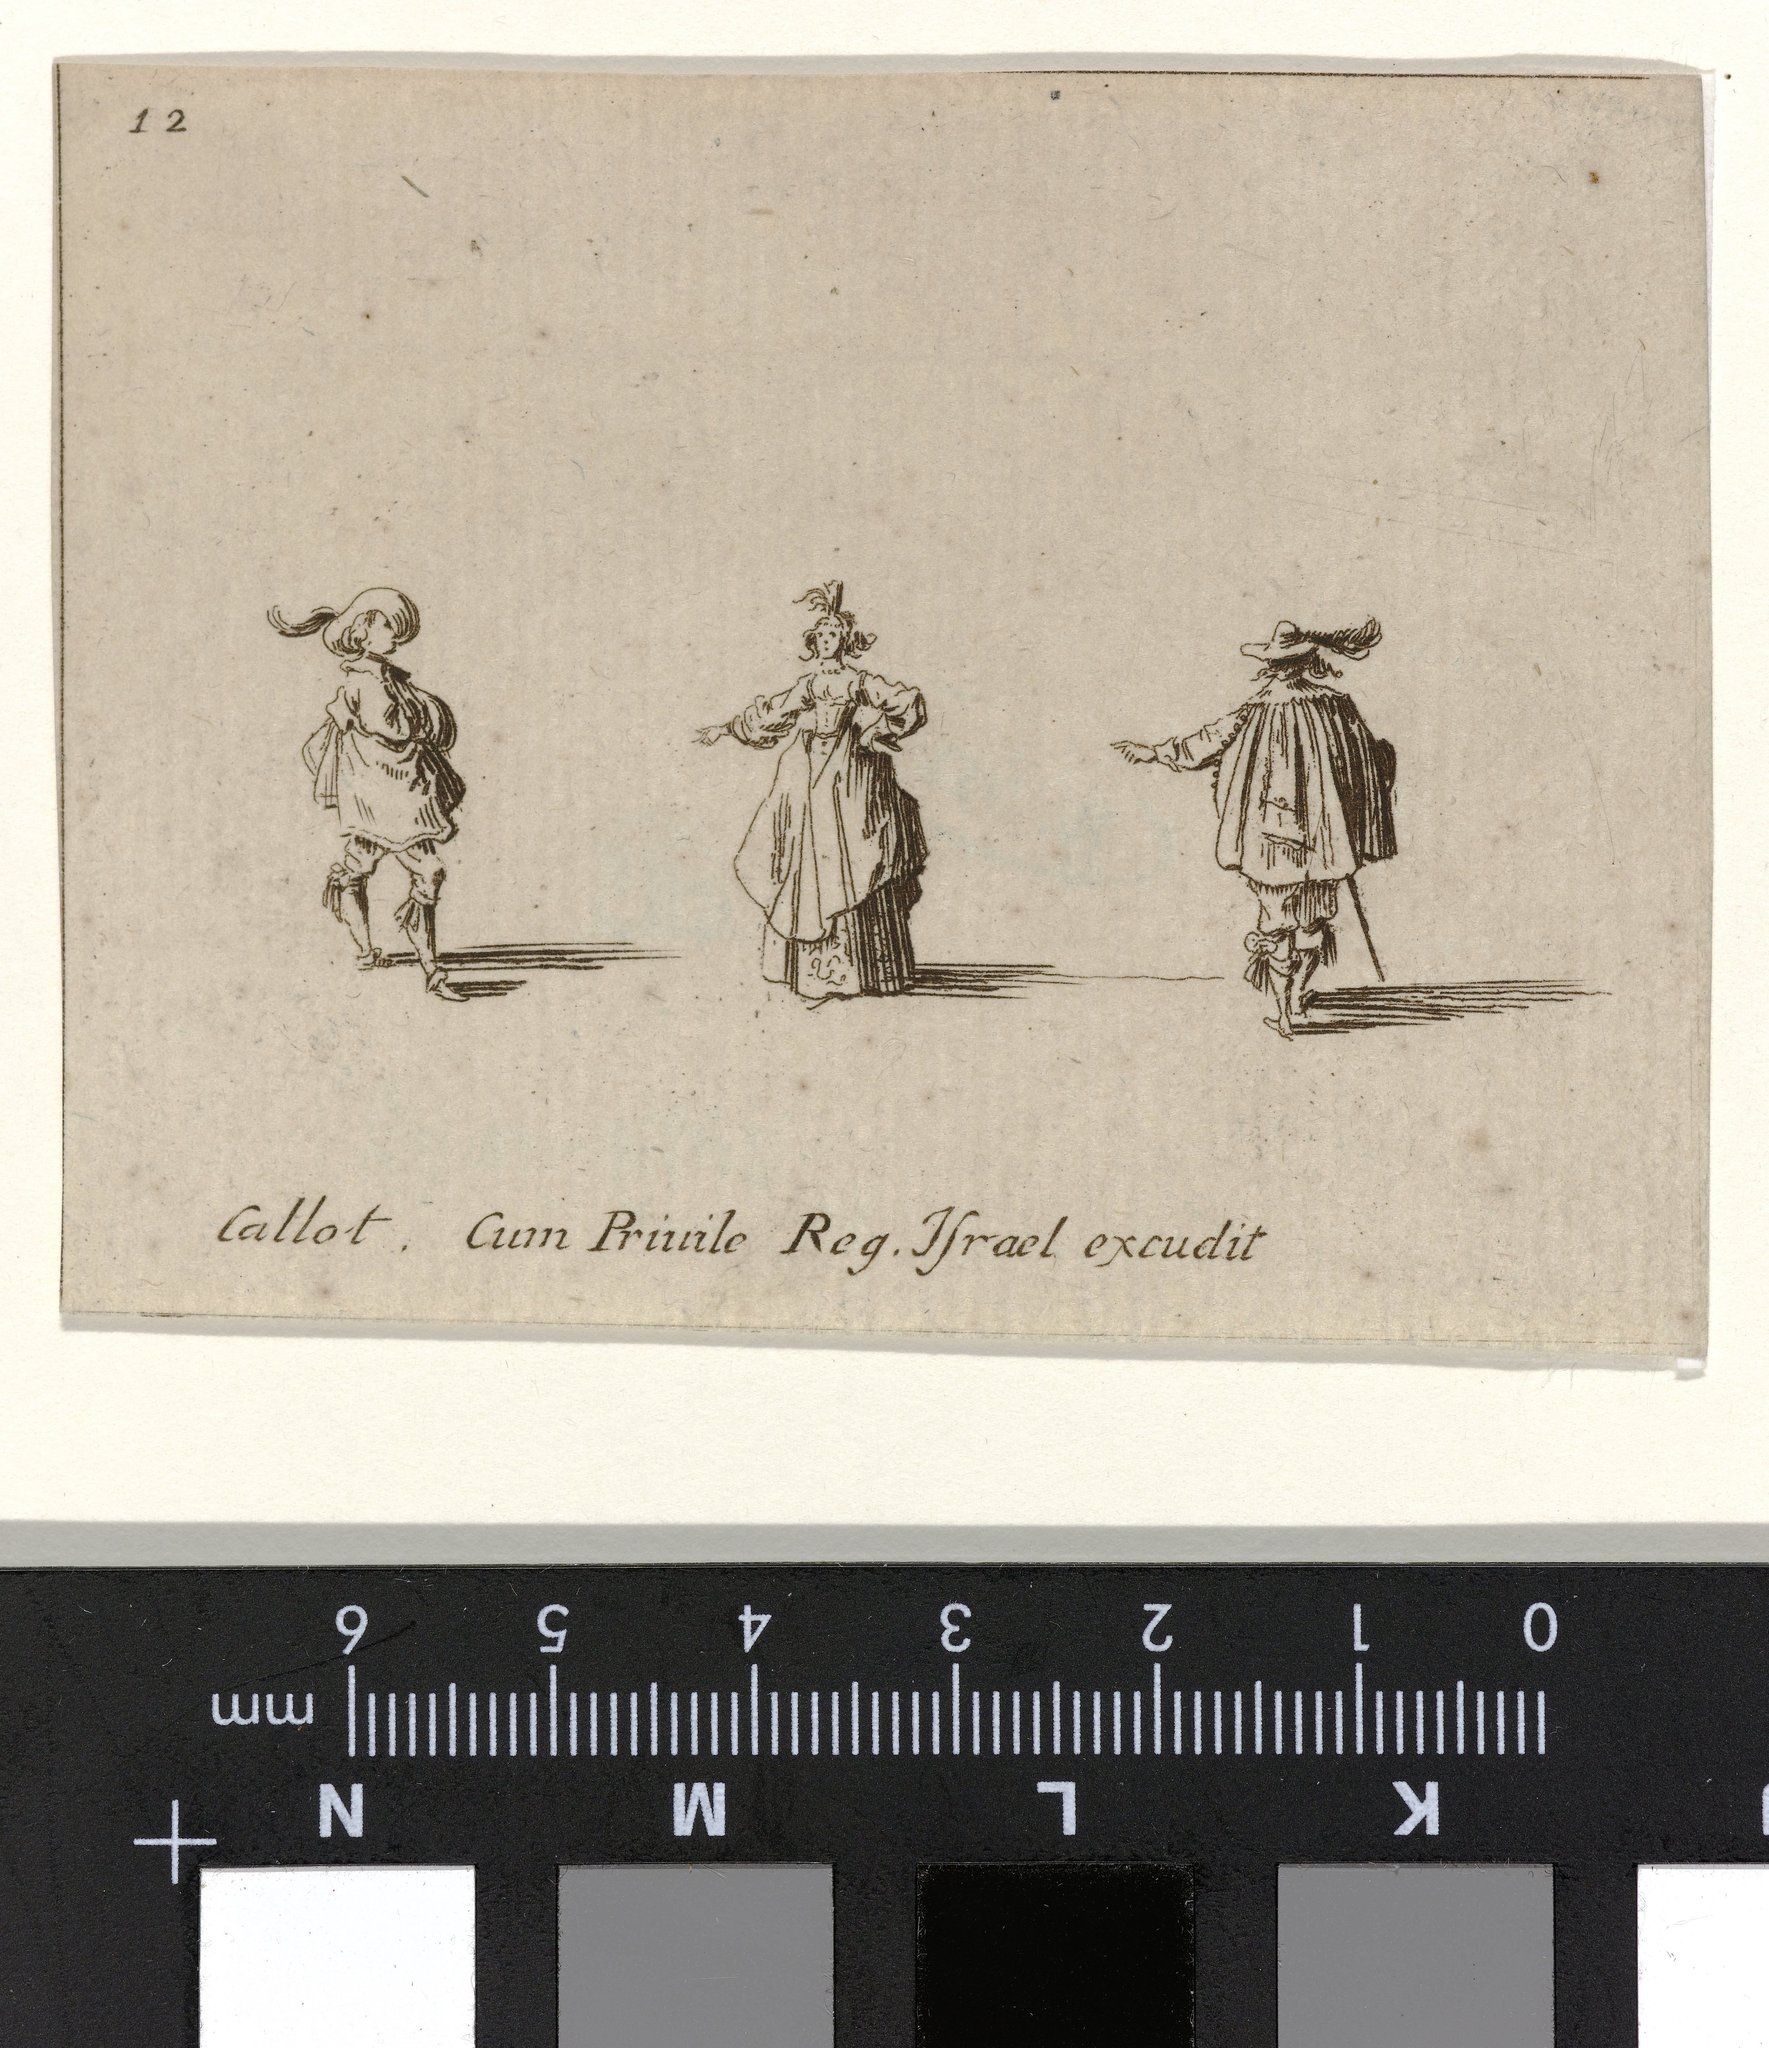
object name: print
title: Drie figuurtjes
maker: israël henriet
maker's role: printer, publisher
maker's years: 1590-1661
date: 1635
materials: paper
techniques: etching